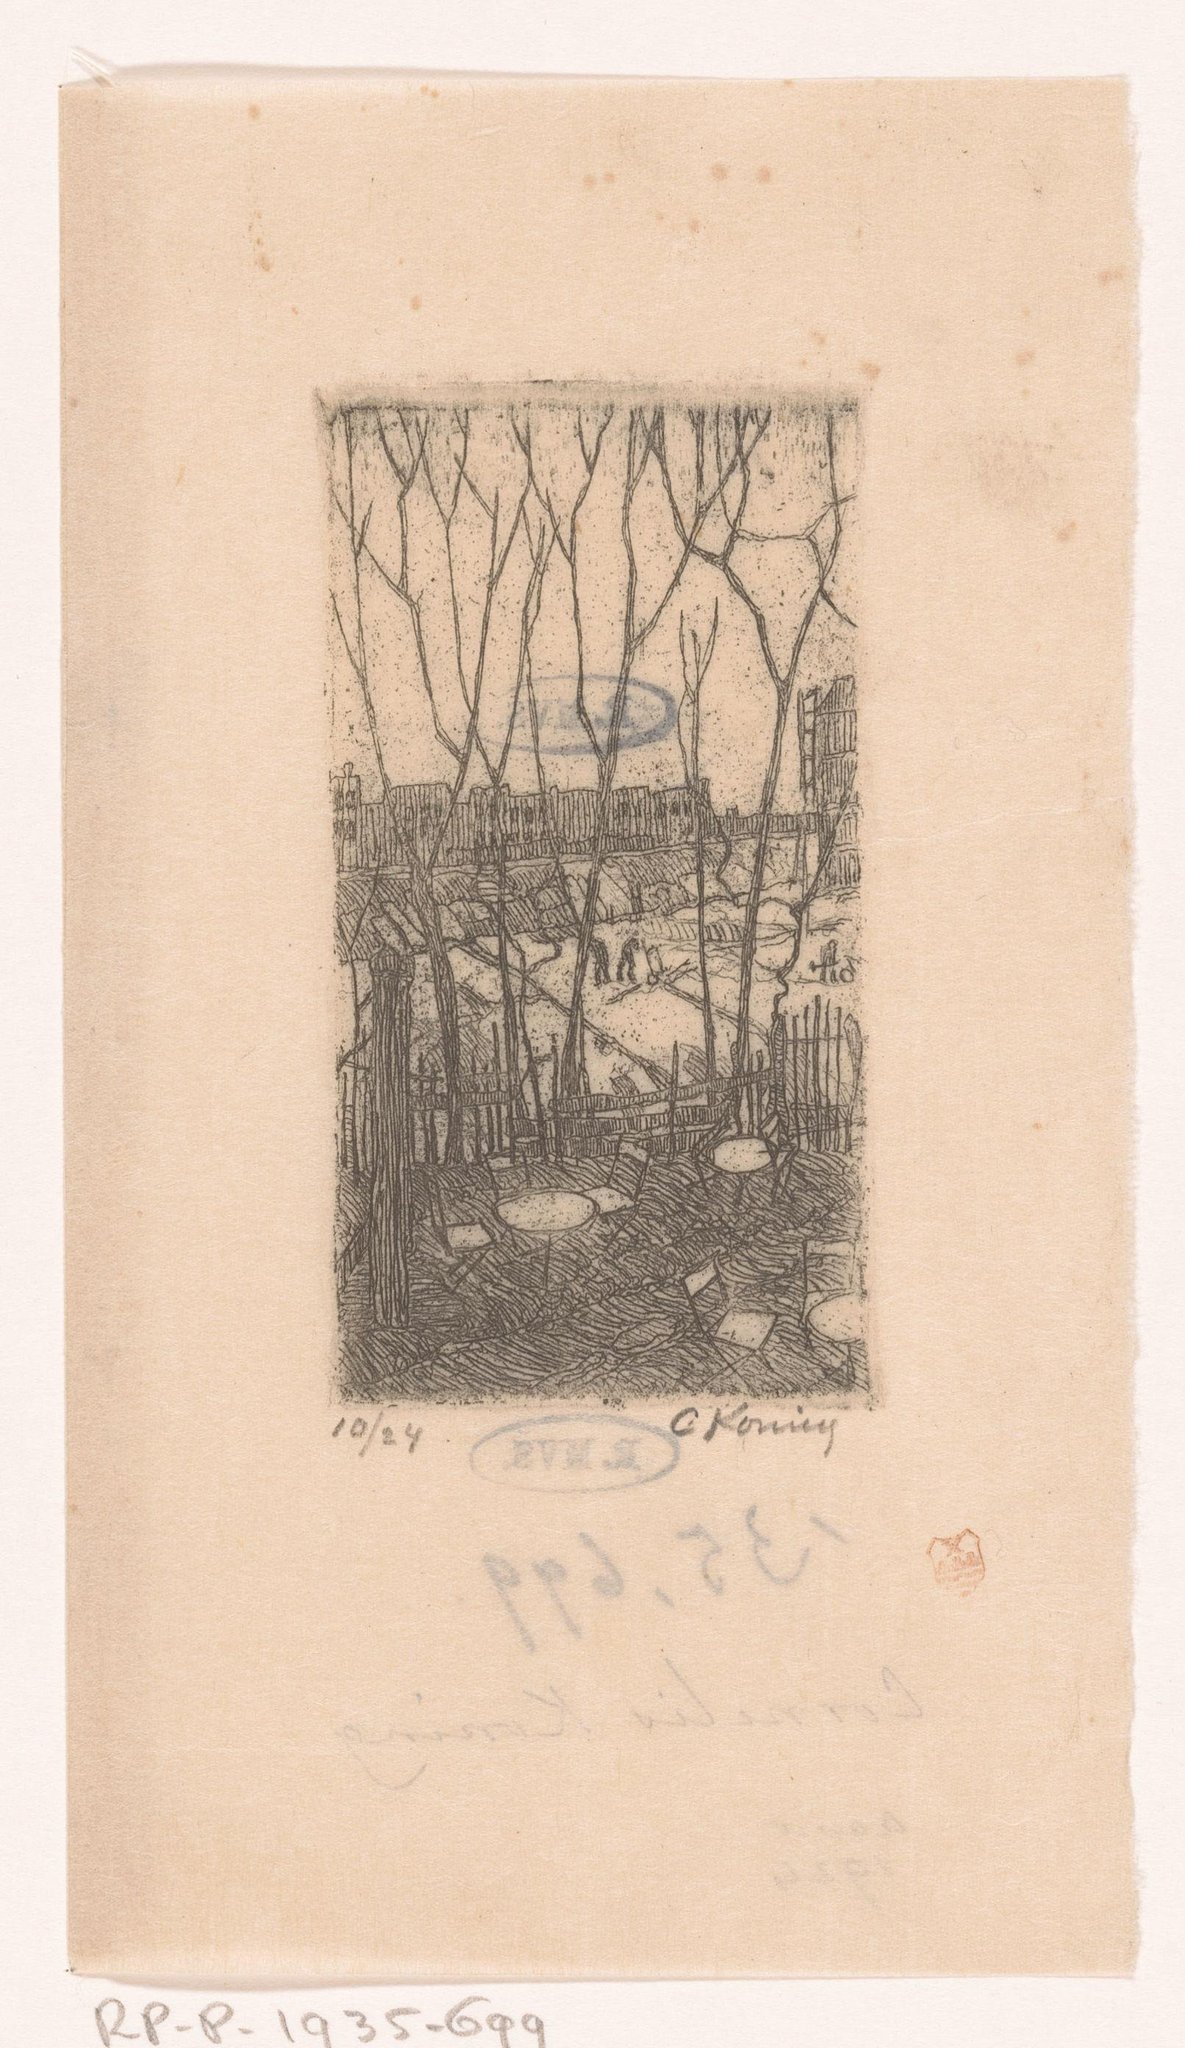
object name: print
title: Terras bij een stad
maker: cornelis koning (1893-1951)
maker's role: print maker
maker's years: 1893-1951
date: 1903-1935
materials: paper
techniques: etching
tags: inn, coffee-house, public house, etc.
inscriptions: collector's mark: Lugt 2760, collector's mark: Lugt 2228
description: Een met bomen begrensd terras met tafels en stoelen. Op de achtergrond bebouwing.